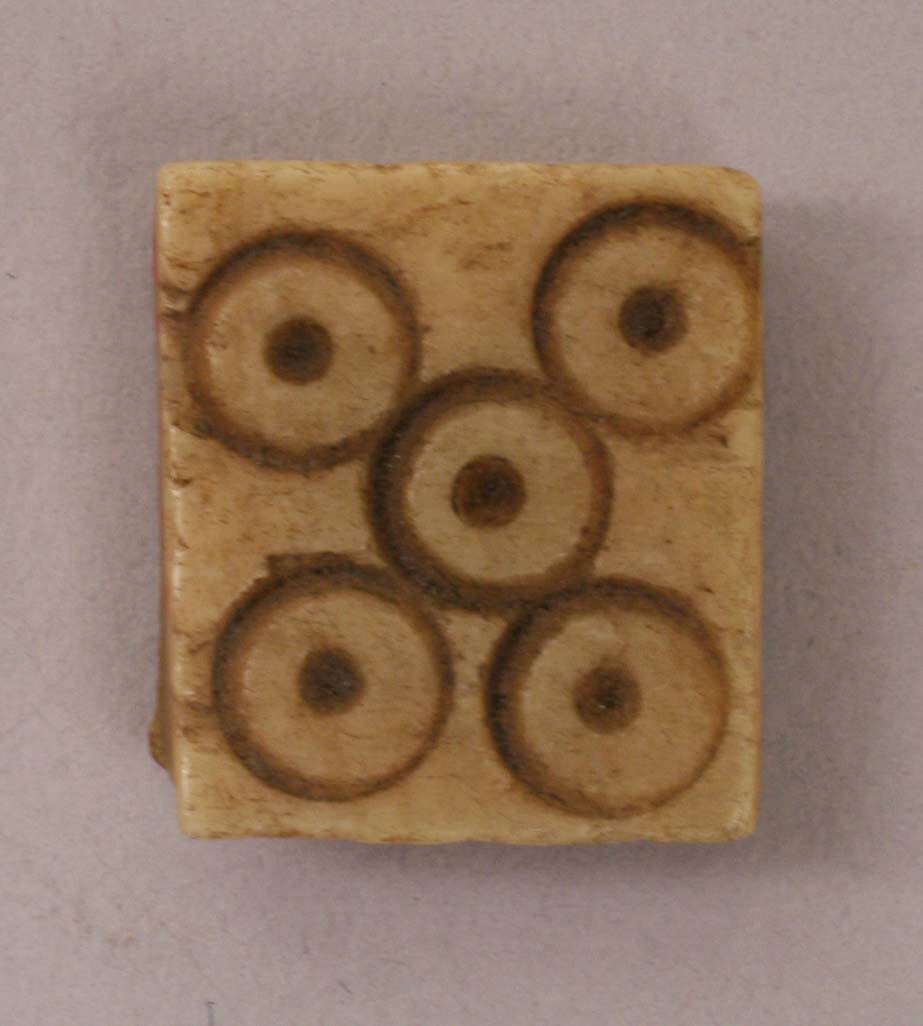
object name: counter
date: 30 BCE-364 CE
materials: bone, paint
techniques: incising, inlay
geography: egypt